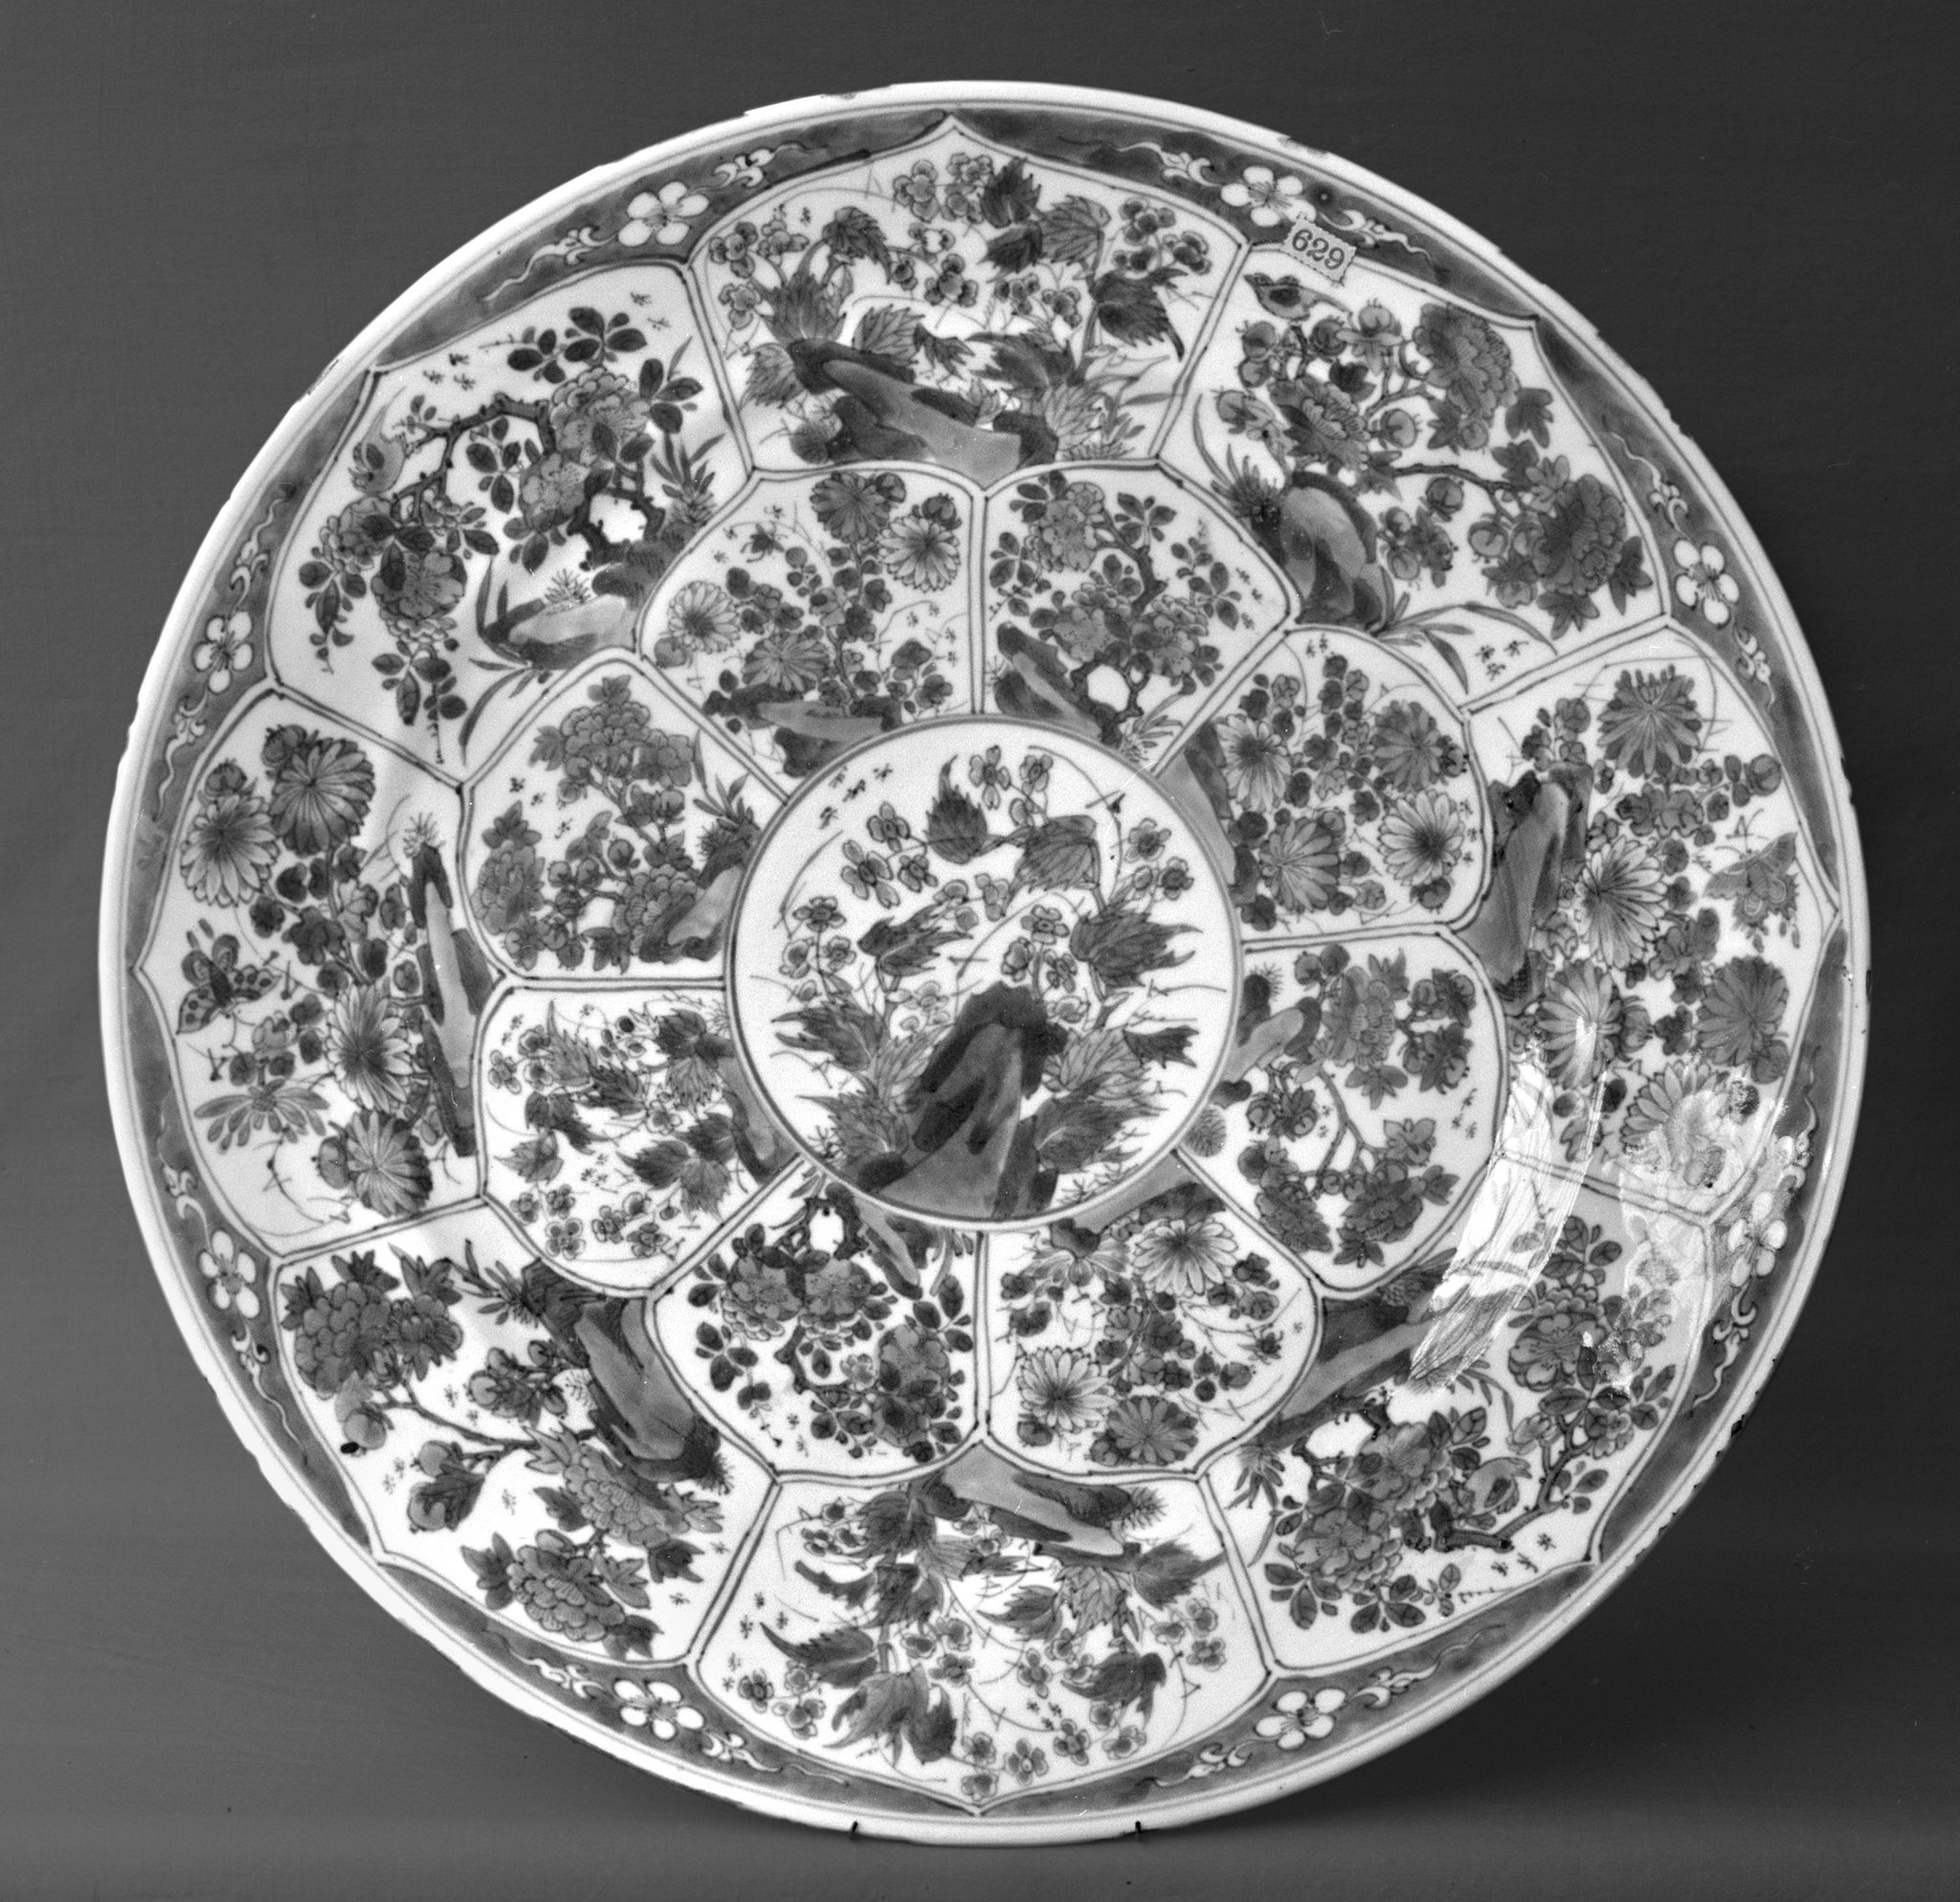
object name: plate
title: Plate with flowers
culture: chinese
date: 1667-1733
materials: cobalt, porcelain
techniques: painting, underglaze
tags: flowers